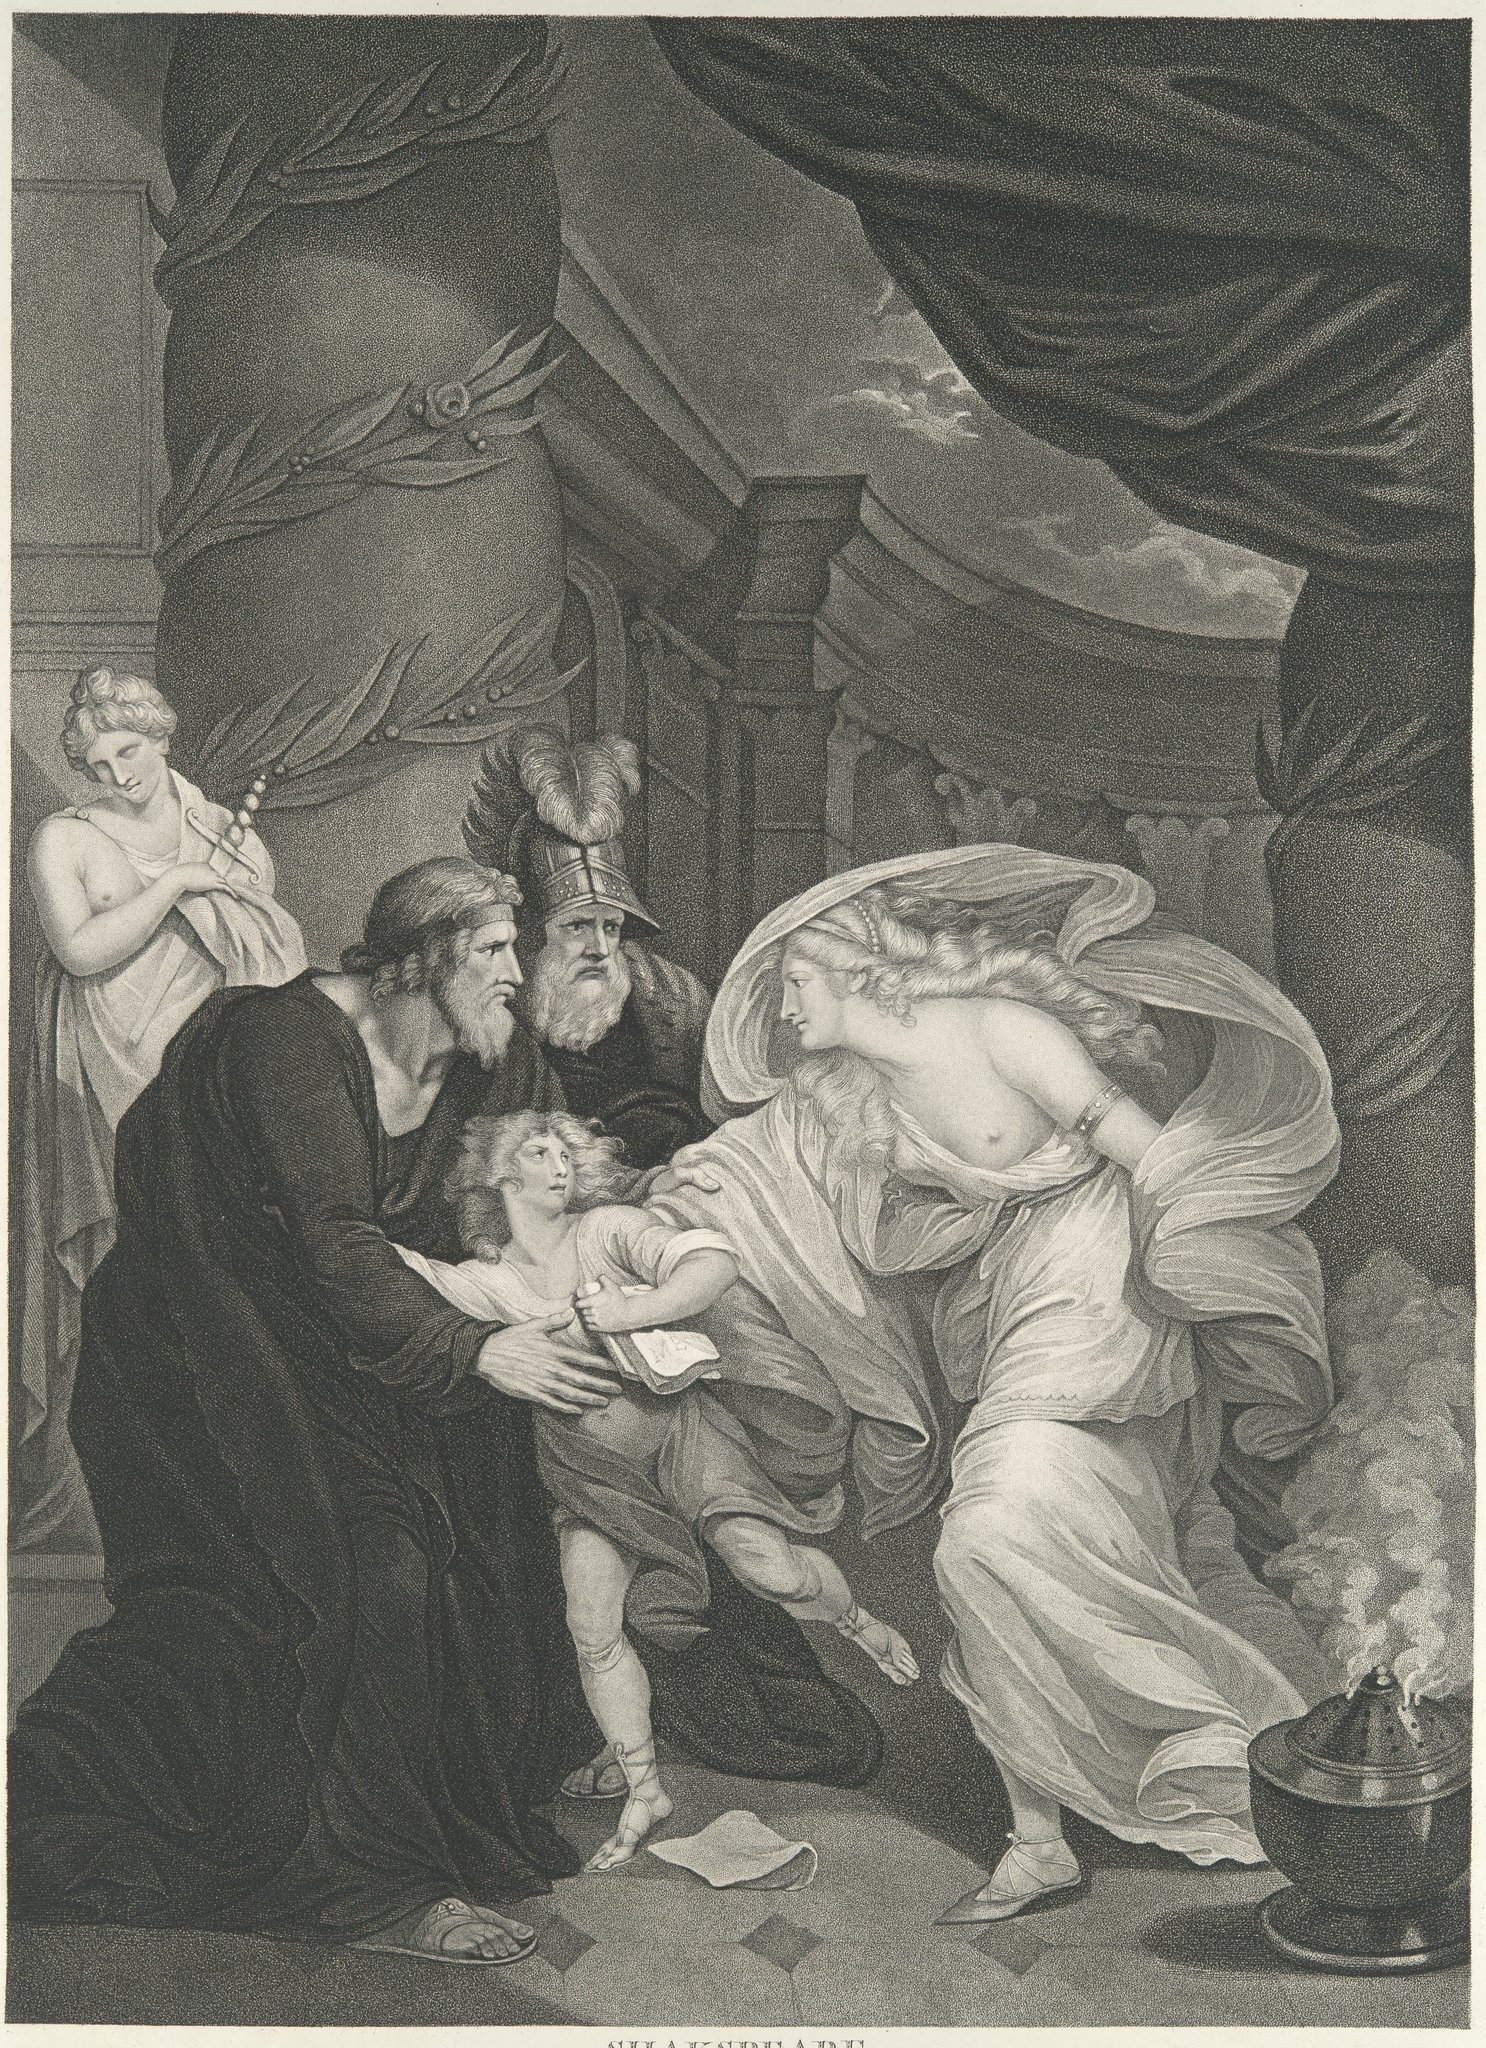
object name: print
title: Rome, Titus's Garden–Lucius Pursued by Lavinia (Shakespeare, Titus Andronicus, Act 4, Scene 1)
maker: thomas kirk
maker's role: artist and engraver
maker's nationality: british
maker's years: 1760-1797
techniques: engraving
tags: shakespeare,boys,men,women